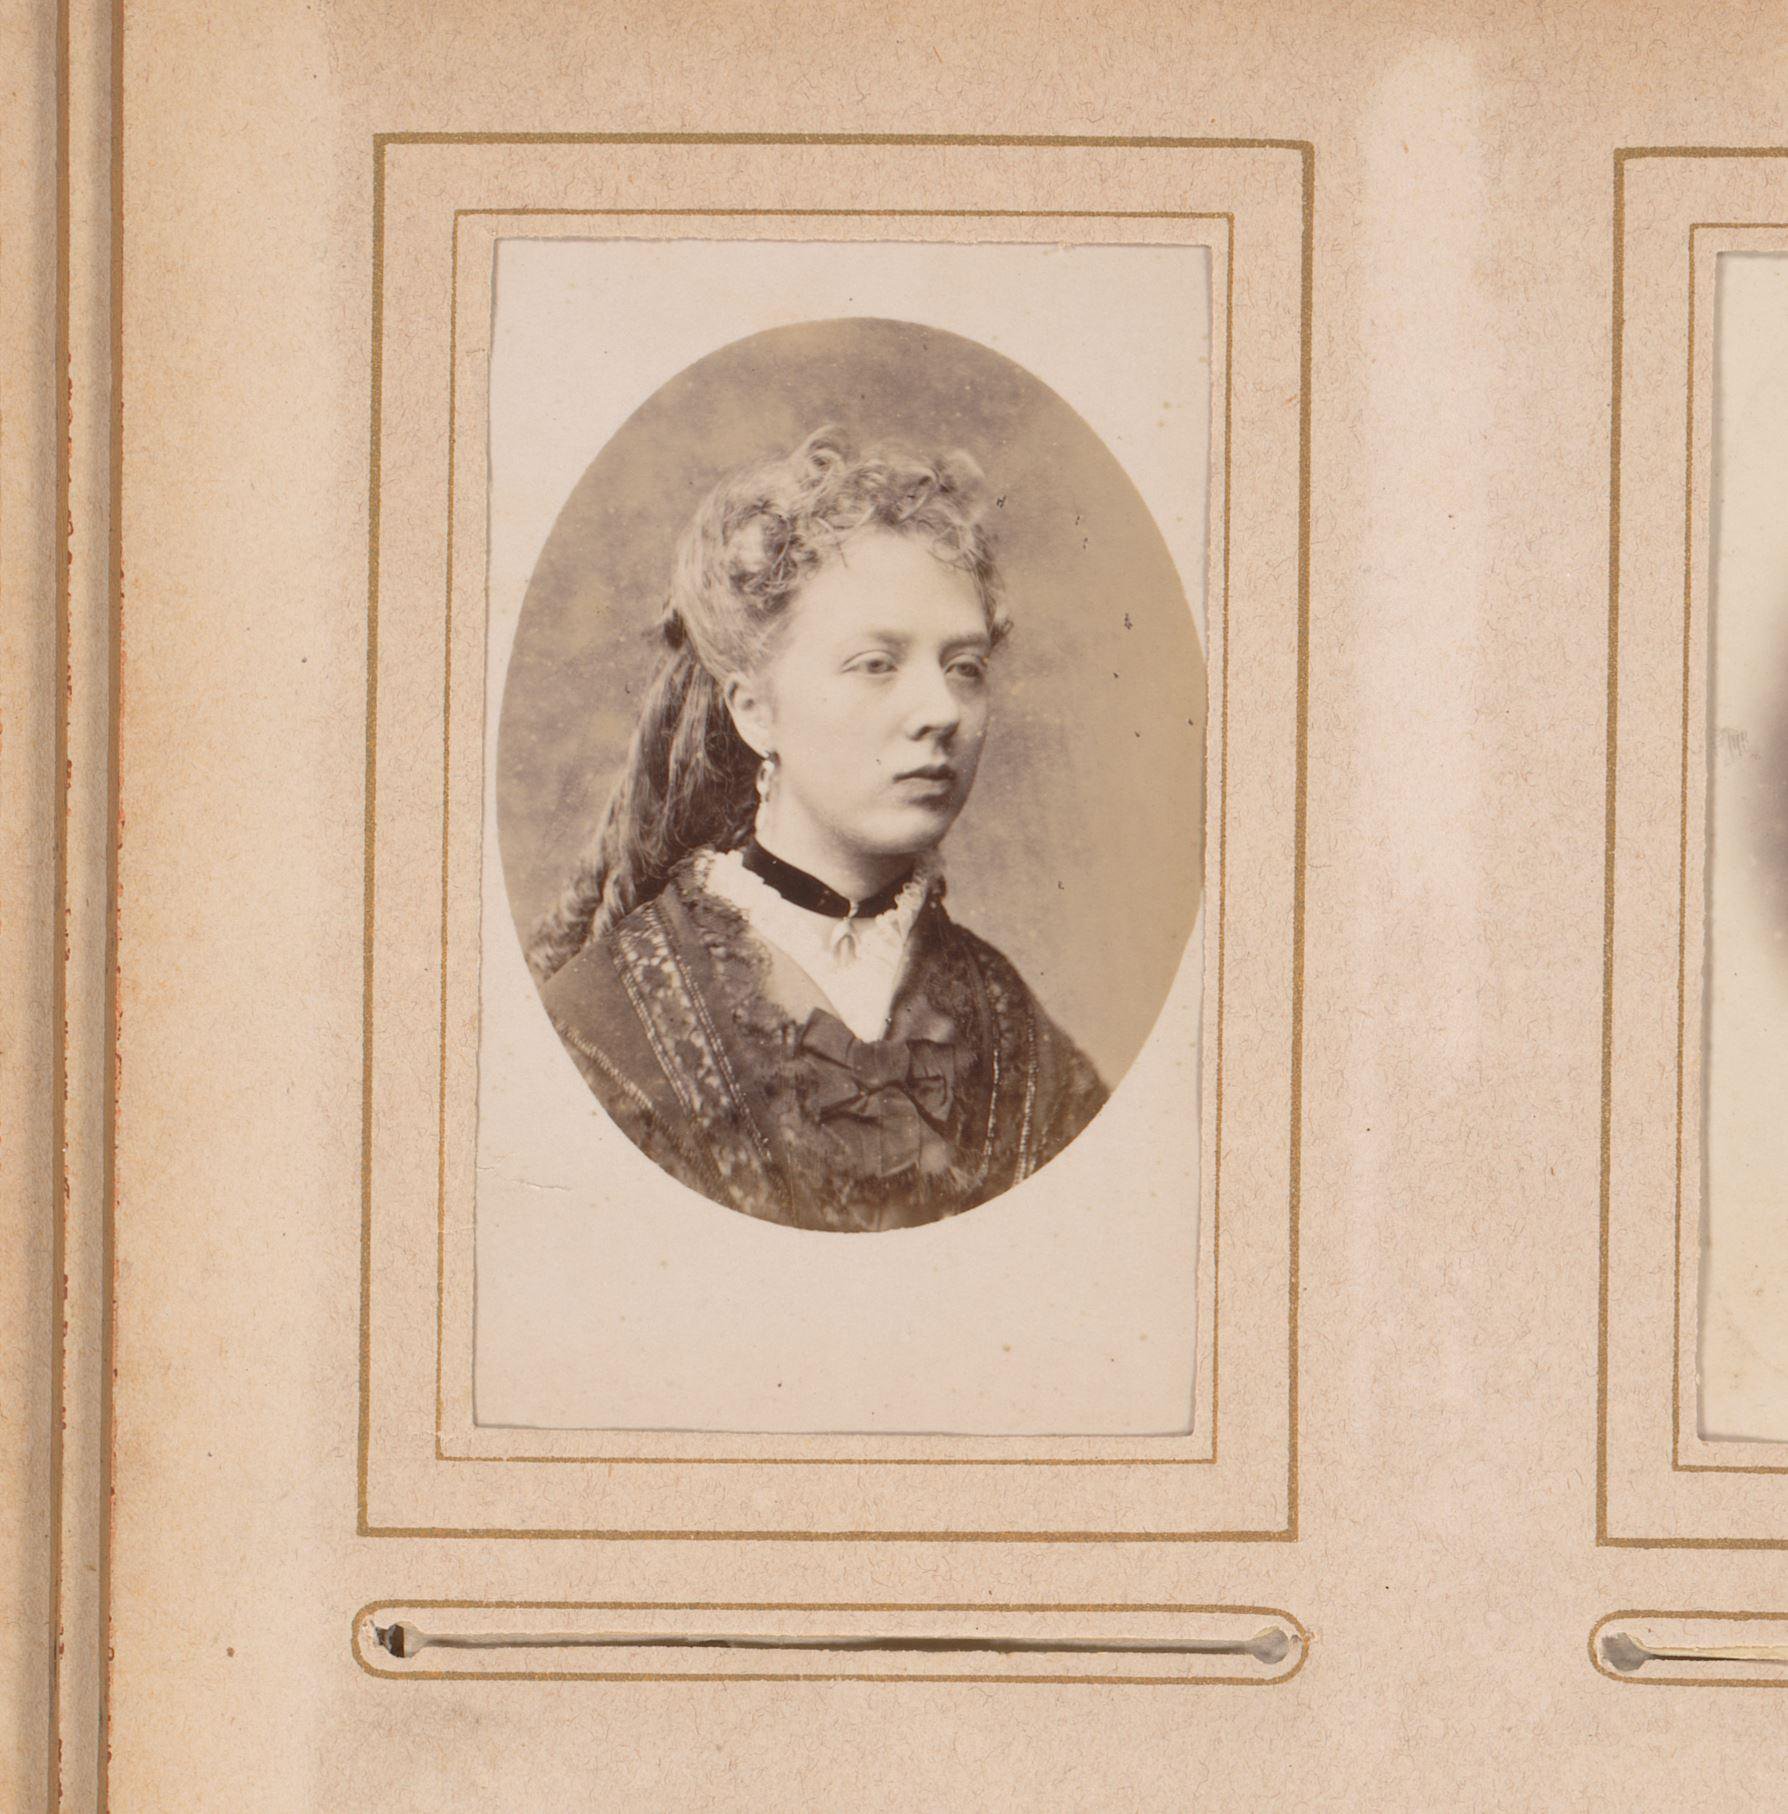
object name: album leaf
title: Portret van een meisje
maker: albert greiner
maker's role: fotograaf, fotostudio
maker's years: 1833-1890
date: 1861-1887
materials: cardboard, photographic support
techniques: albumen print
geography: amsterdam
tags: historical persons - bb - woman, girl (child between toddler and youth)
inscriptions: inscription: ‘A. Greiner/ Photograf/ Amsterdam/ Nieuwendijk L.89’